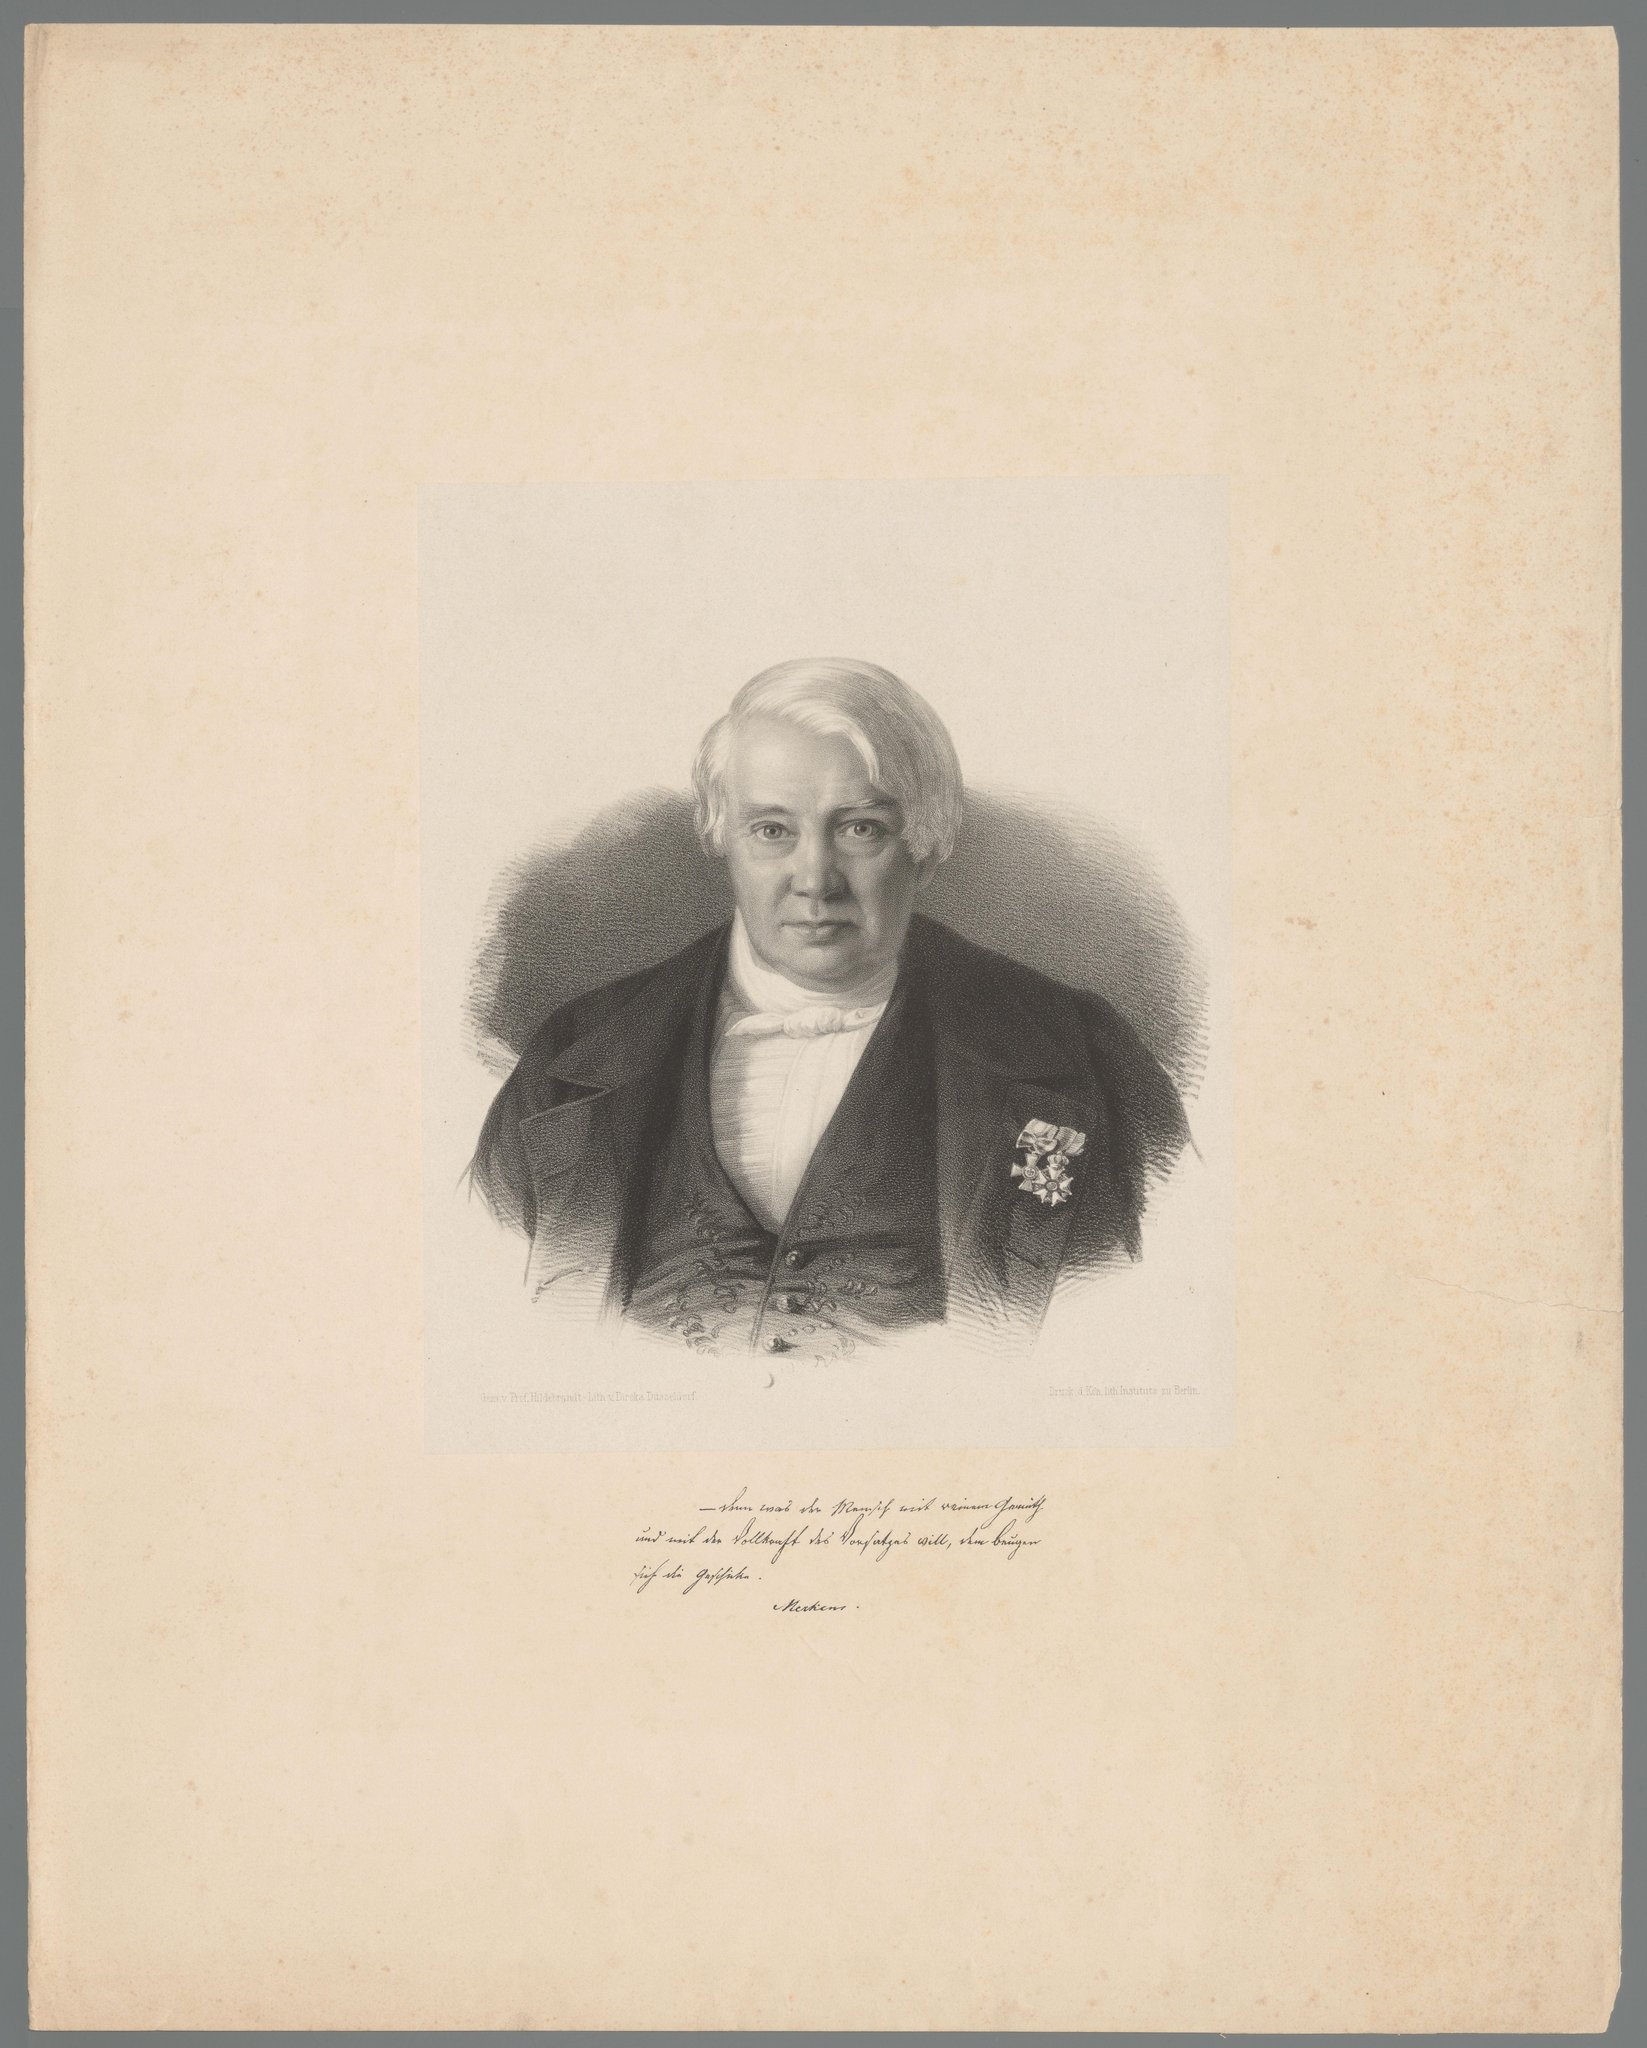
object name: print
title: Portret van Peter Heinrich Merkens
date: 1816-1871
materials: paper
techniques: lithograph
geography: berlin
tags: adult man, historical persons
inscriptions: collector's mark: Lugt 2228